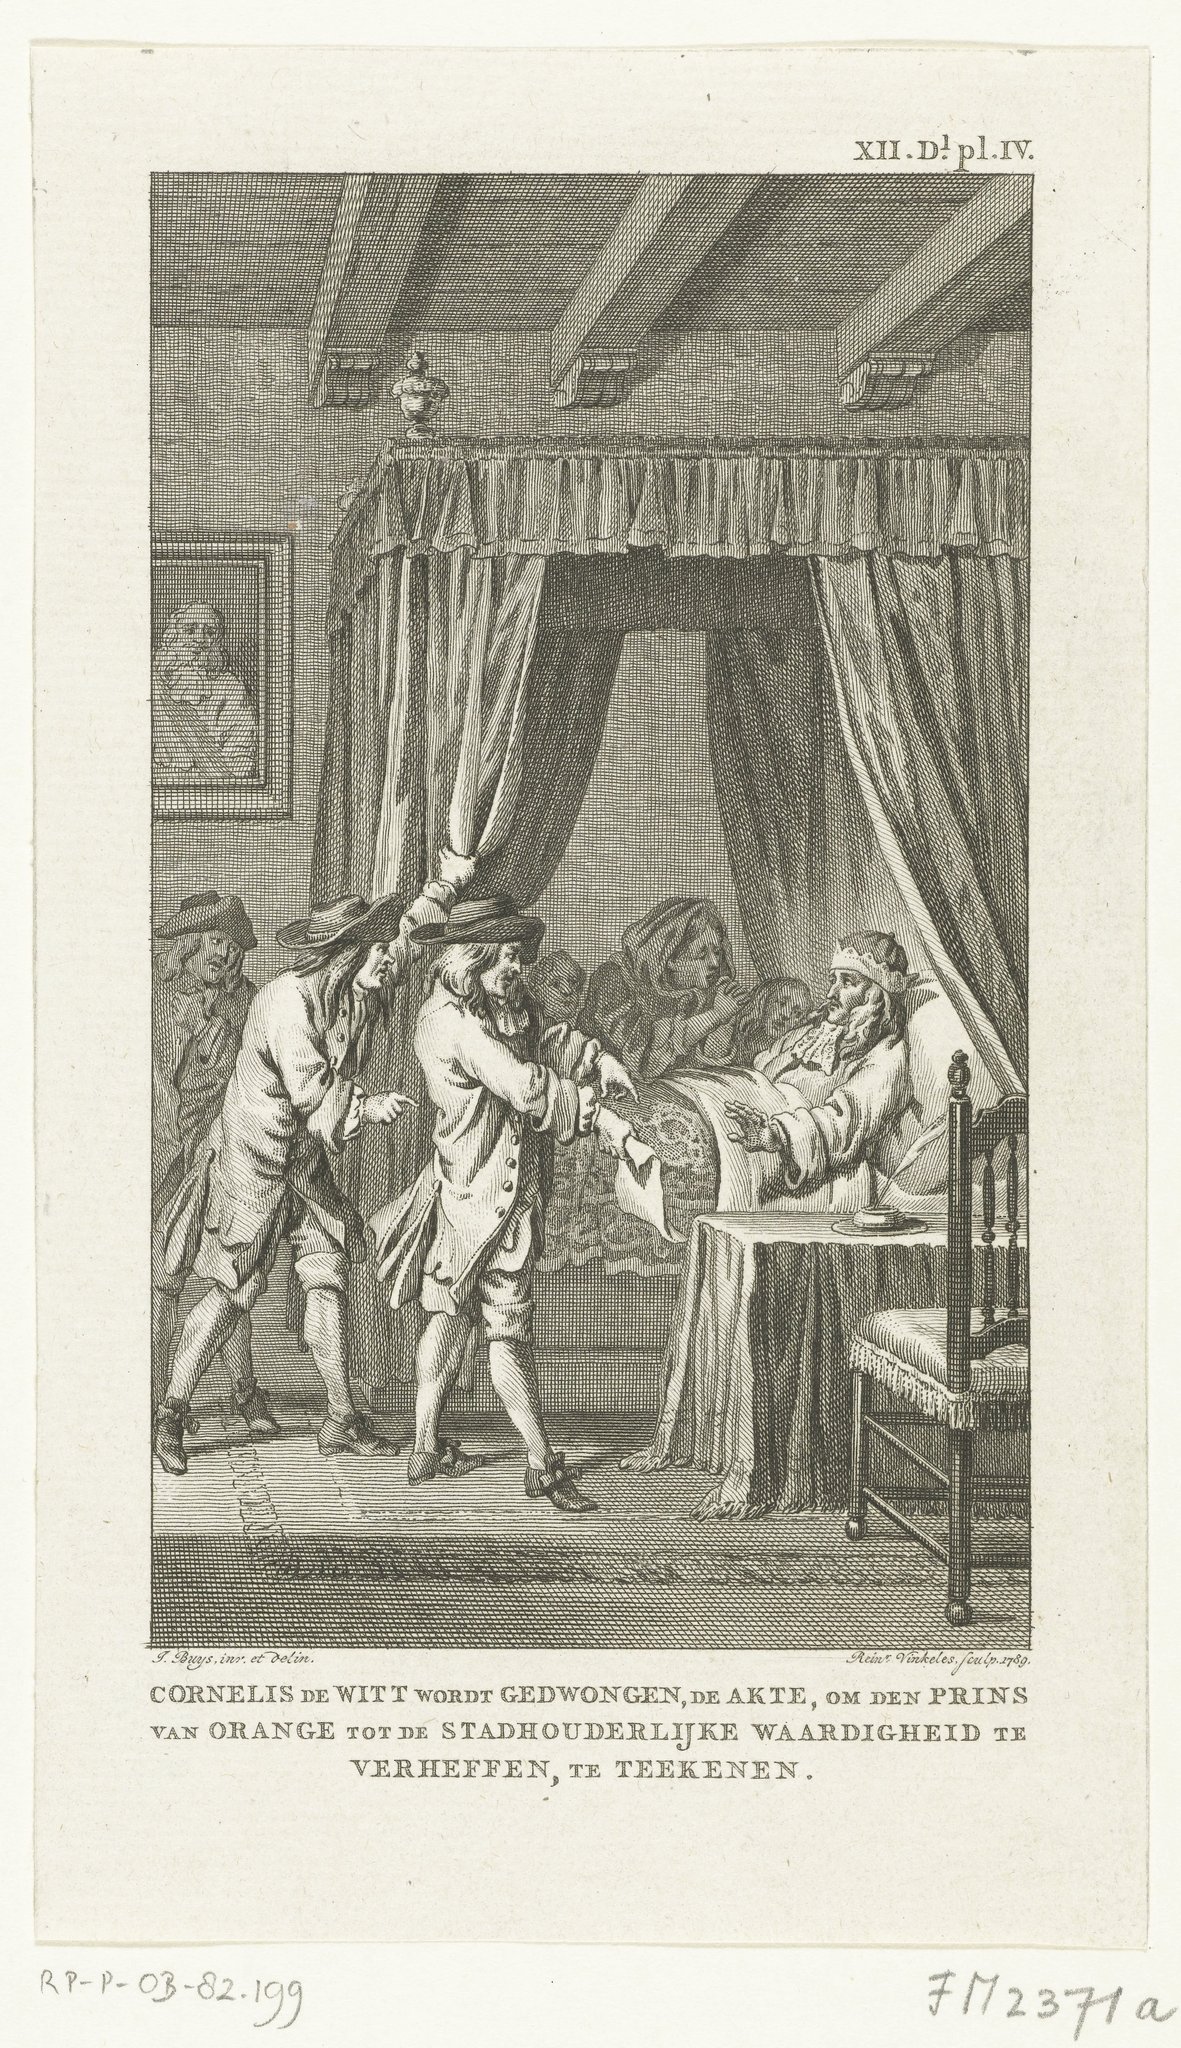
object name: print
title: Burgers van Dordrecht dwingen Cornelis de Witt het Eeuwig Edict in te trekken, 1672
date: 1789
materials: paper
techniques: etching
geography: northern netherlands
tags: dordrecht, cornelis de witt, rampjaar (disaster year)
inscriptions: date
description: Gebruikt als illustratie in: Jacobus Kok, Vaderlandsch Woordenboek, Johannes Allart, Amsterdam 1785-1799, 35 delen, dl. XII, pl. IV.